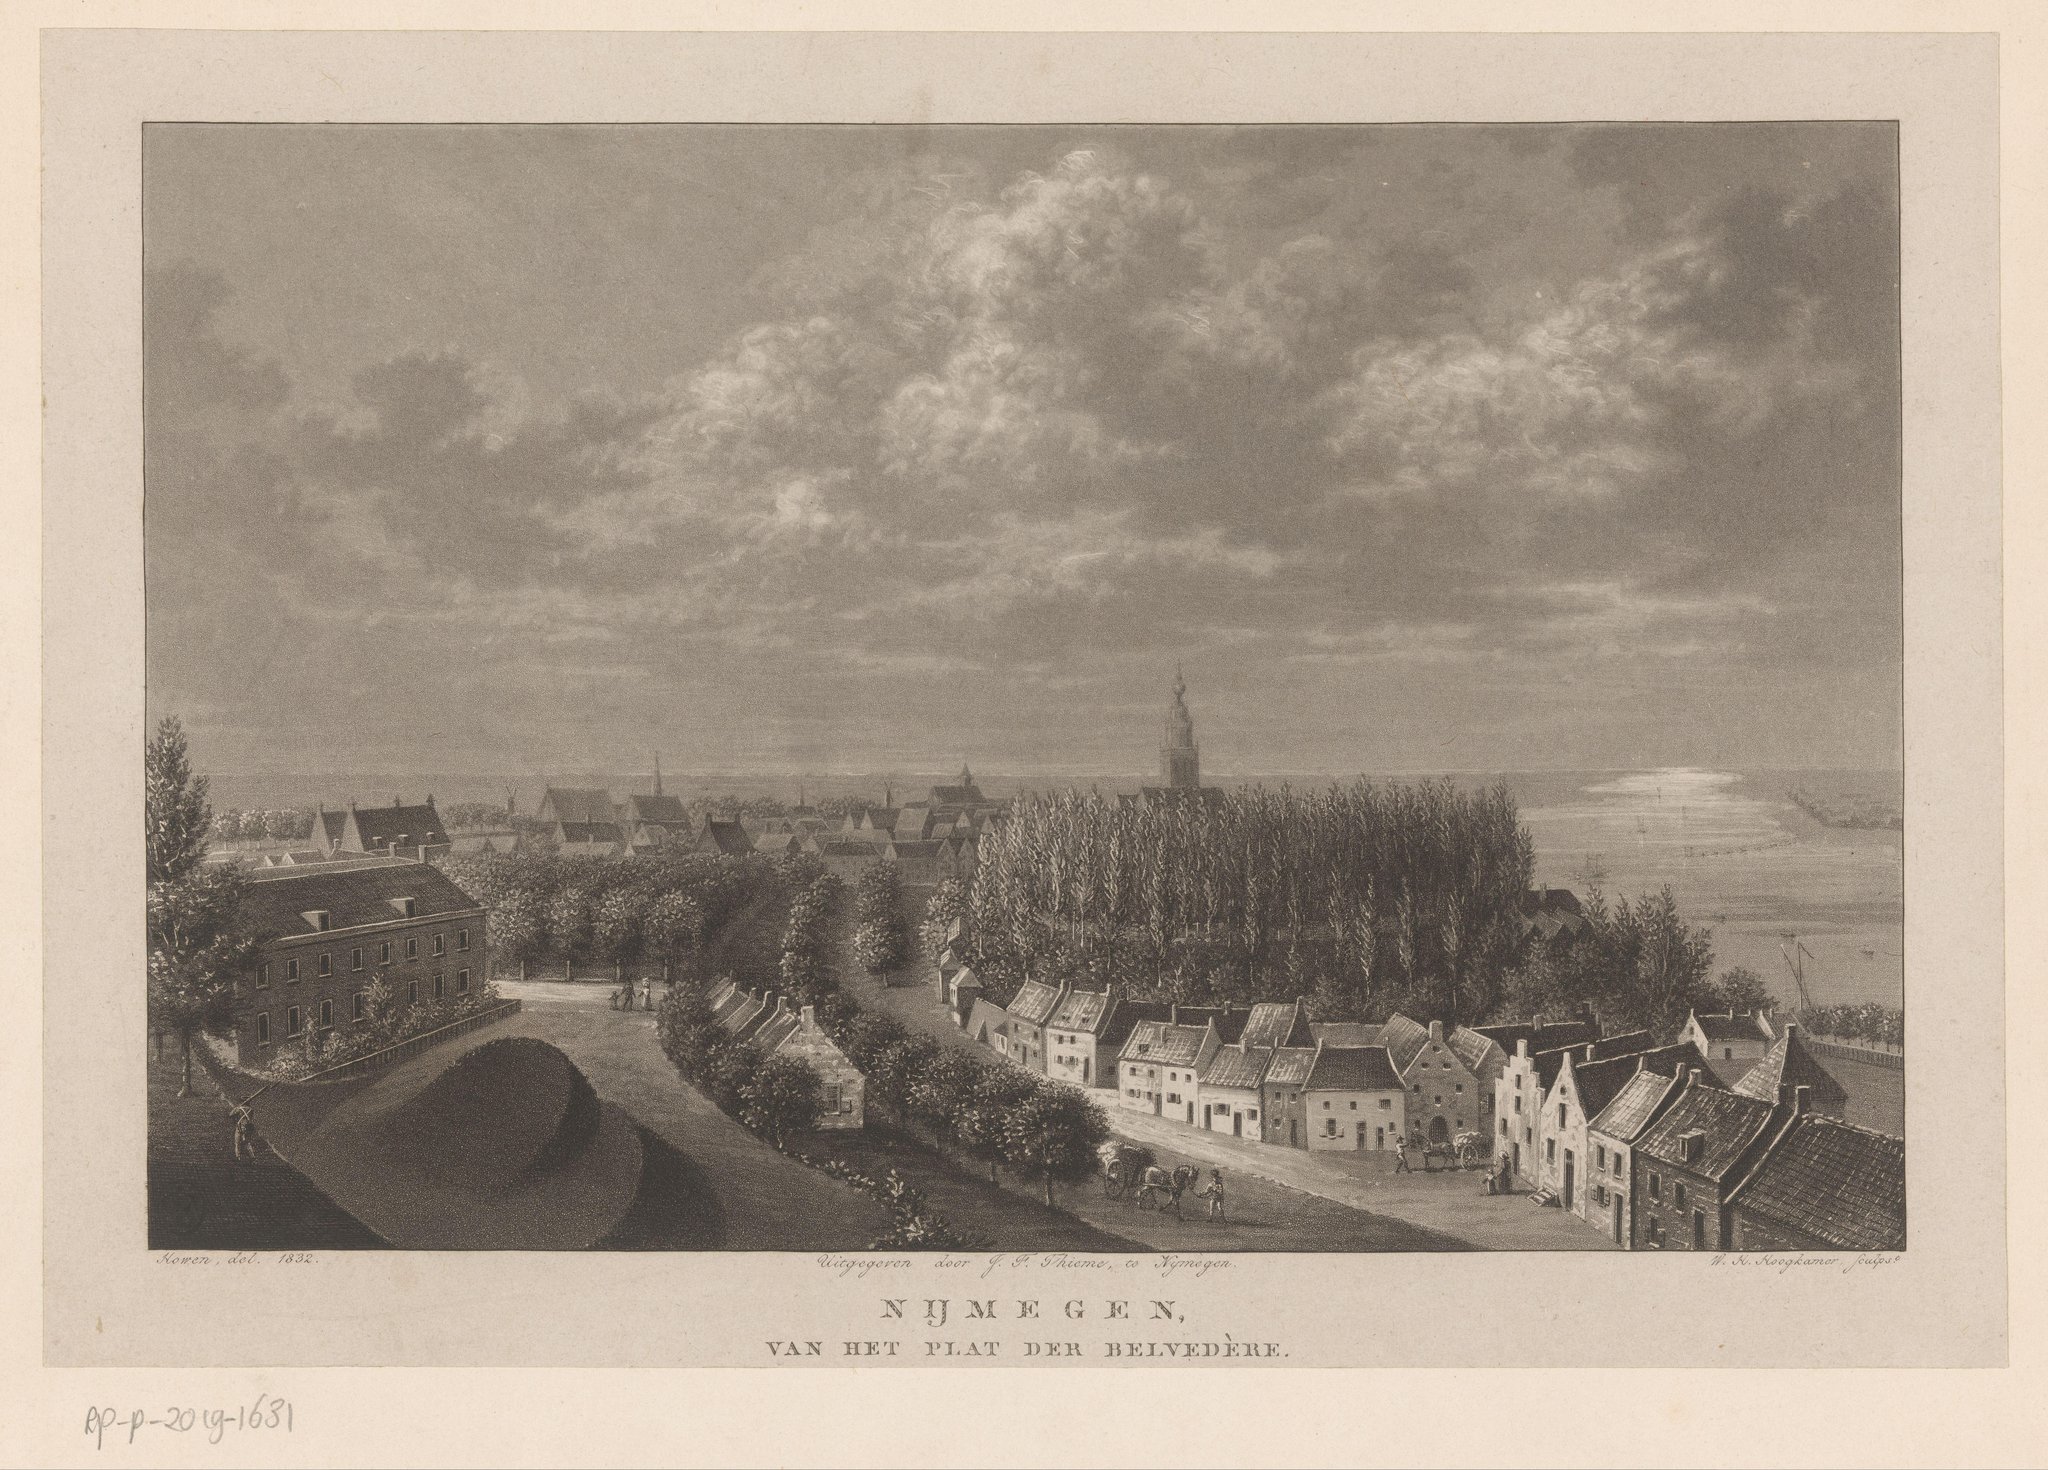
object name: print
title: Zestal Nijmeegsche gezigten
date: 1832-1833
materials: paper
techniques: aquatint, etching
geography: netherlands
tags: city-view, and landscape with man-made constructions, canals, waters (in city), nijmegen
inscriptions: collector's mark: Lugt 3973